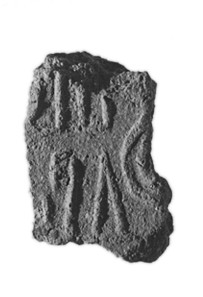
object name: sealing fragment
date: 2030-1640 BCE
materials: clay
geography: egypt